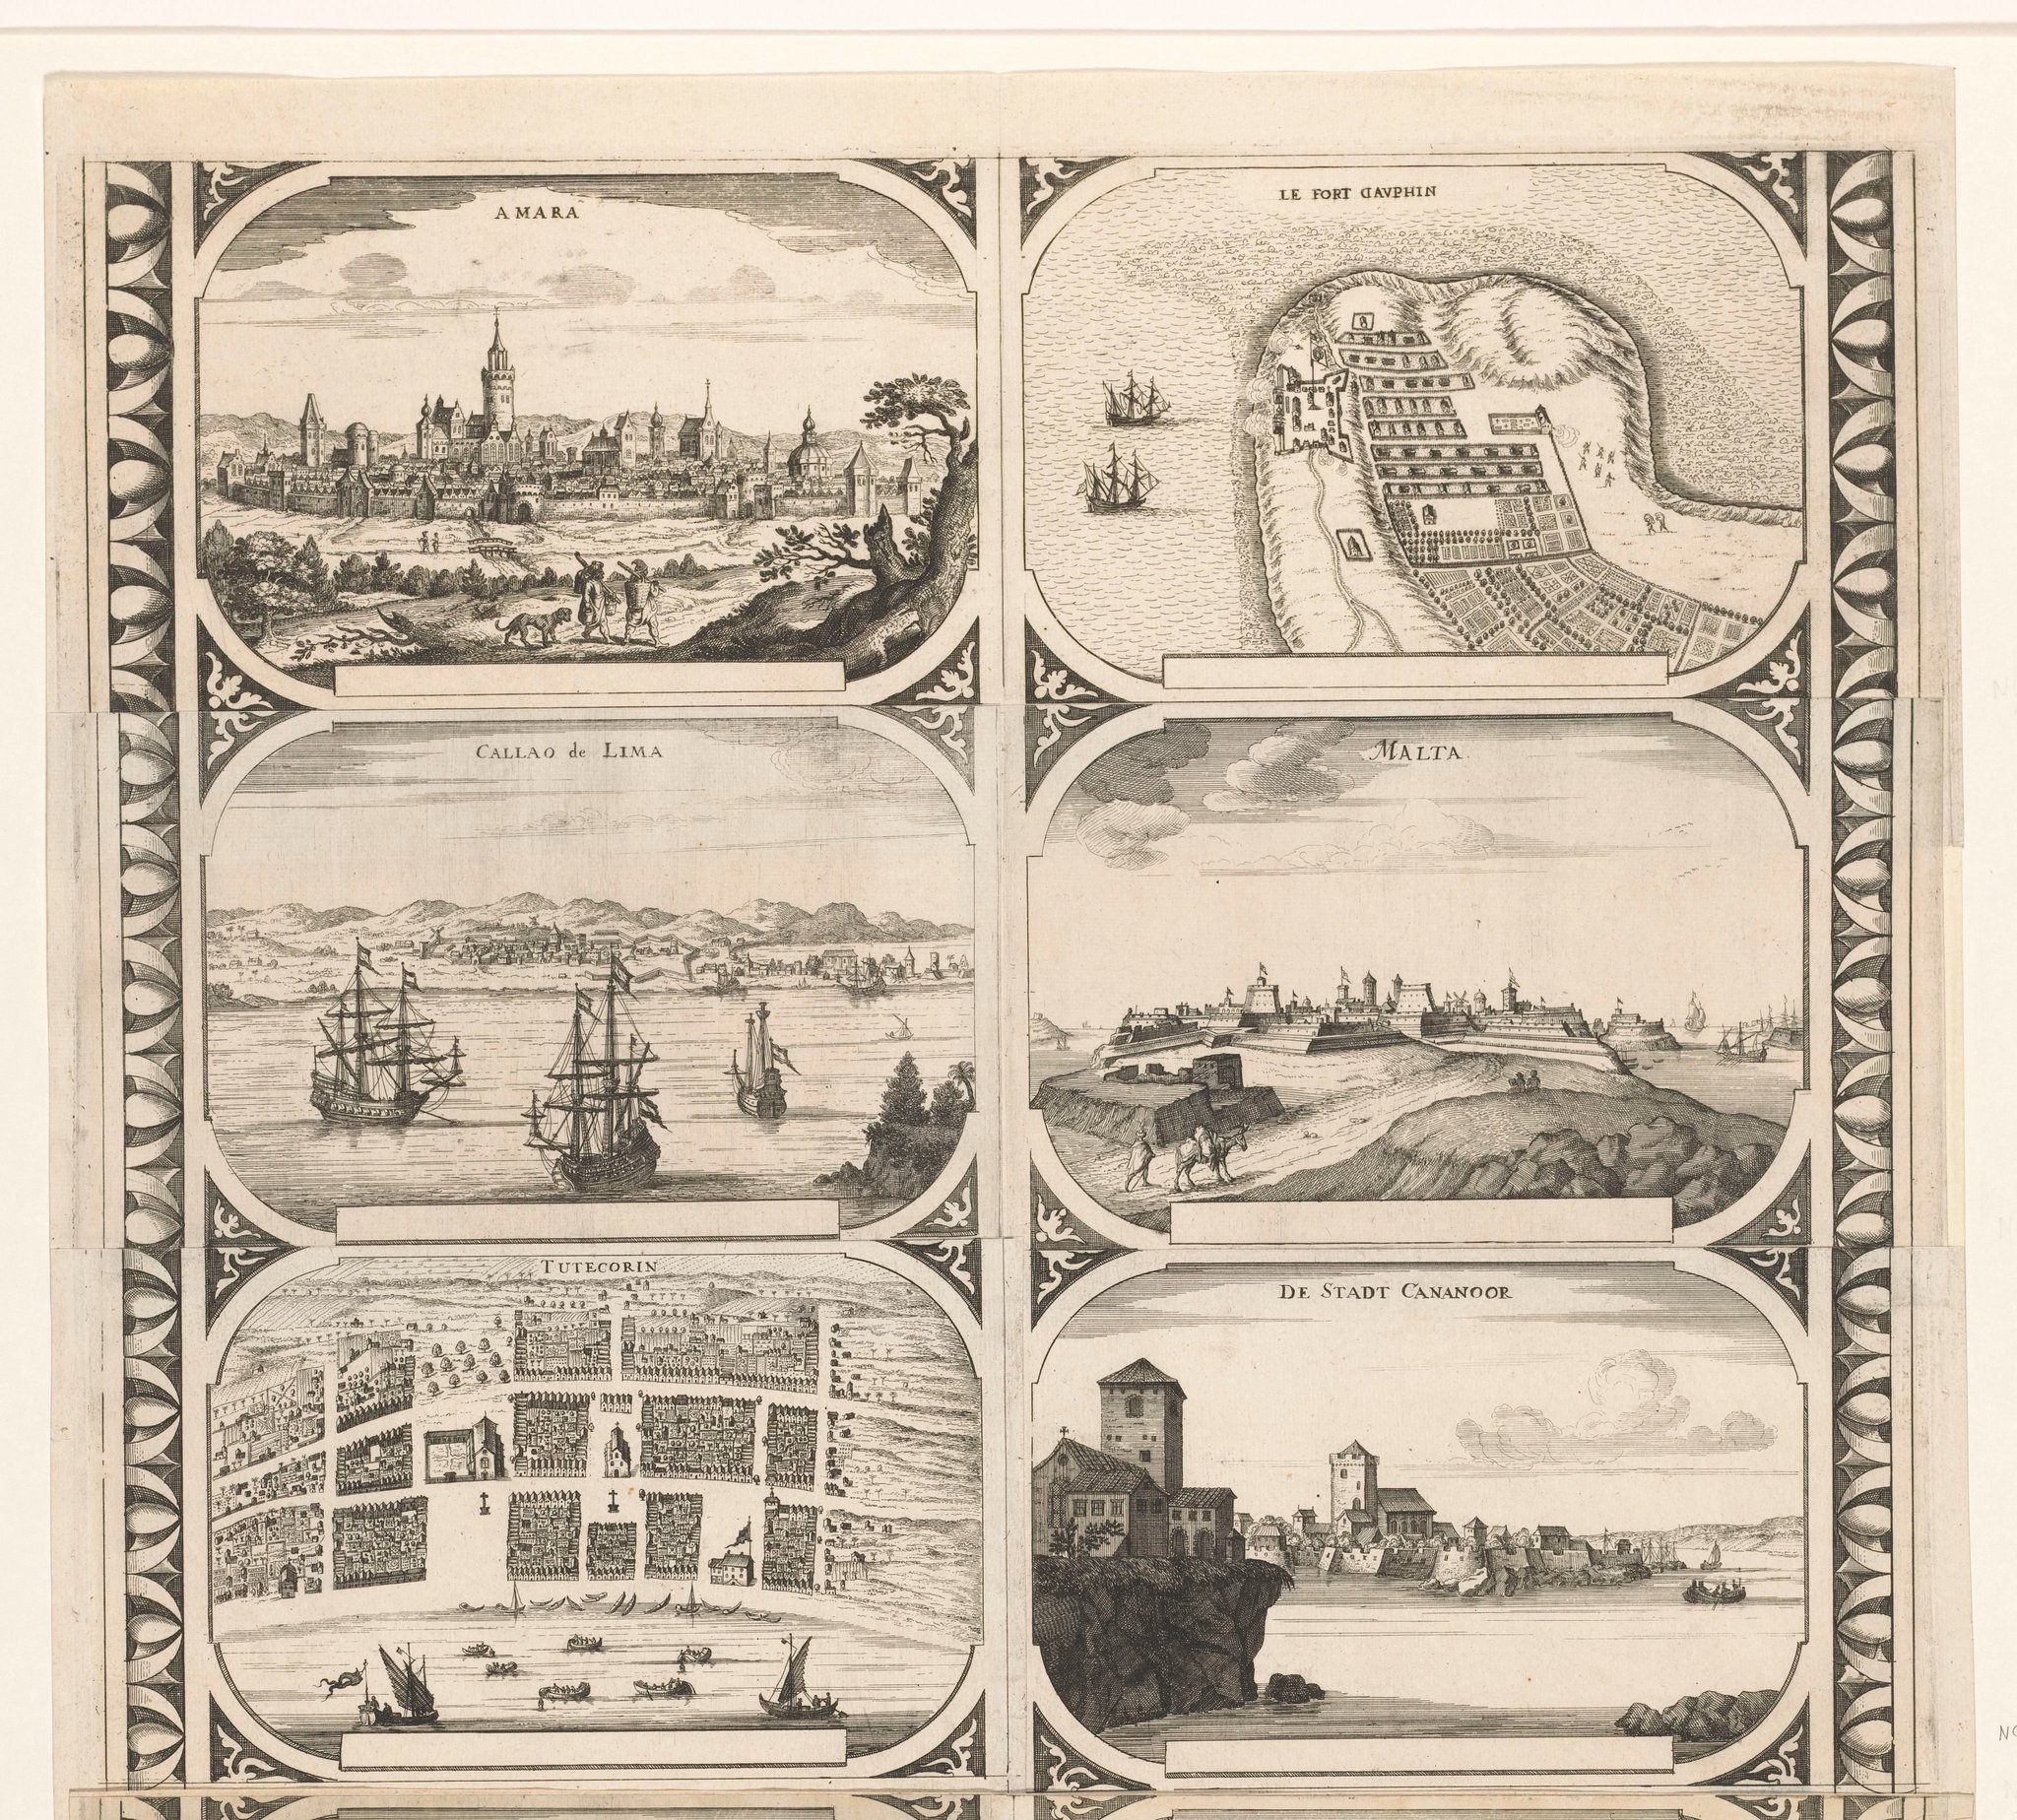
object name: map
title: Amara / Callao de Lima / Tutecorin / Le Fort Davphin / Malta / De Stadt Cananoor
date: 1670-1672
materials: paper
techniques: etching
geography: amsterdam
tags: maps of cities, prospect of city, town panorama, silhouette of city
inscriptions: number: ‘N.G.20.o / N.G.20j / N.G.20.k / N.G.20 / N.G.20N’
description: Blad samengesteld uit zes losse aan elkaar geplakte plattegronden van of gezichten op diverse steden: Amara (India of Irak), Callao, Tuticorin, Fort Dauphin bij Tôlanaro op Madagaskar, Malta en Cananor. Randfiguren bedoeld om als omlijsting om een kaart van een werelddeel te plakken.